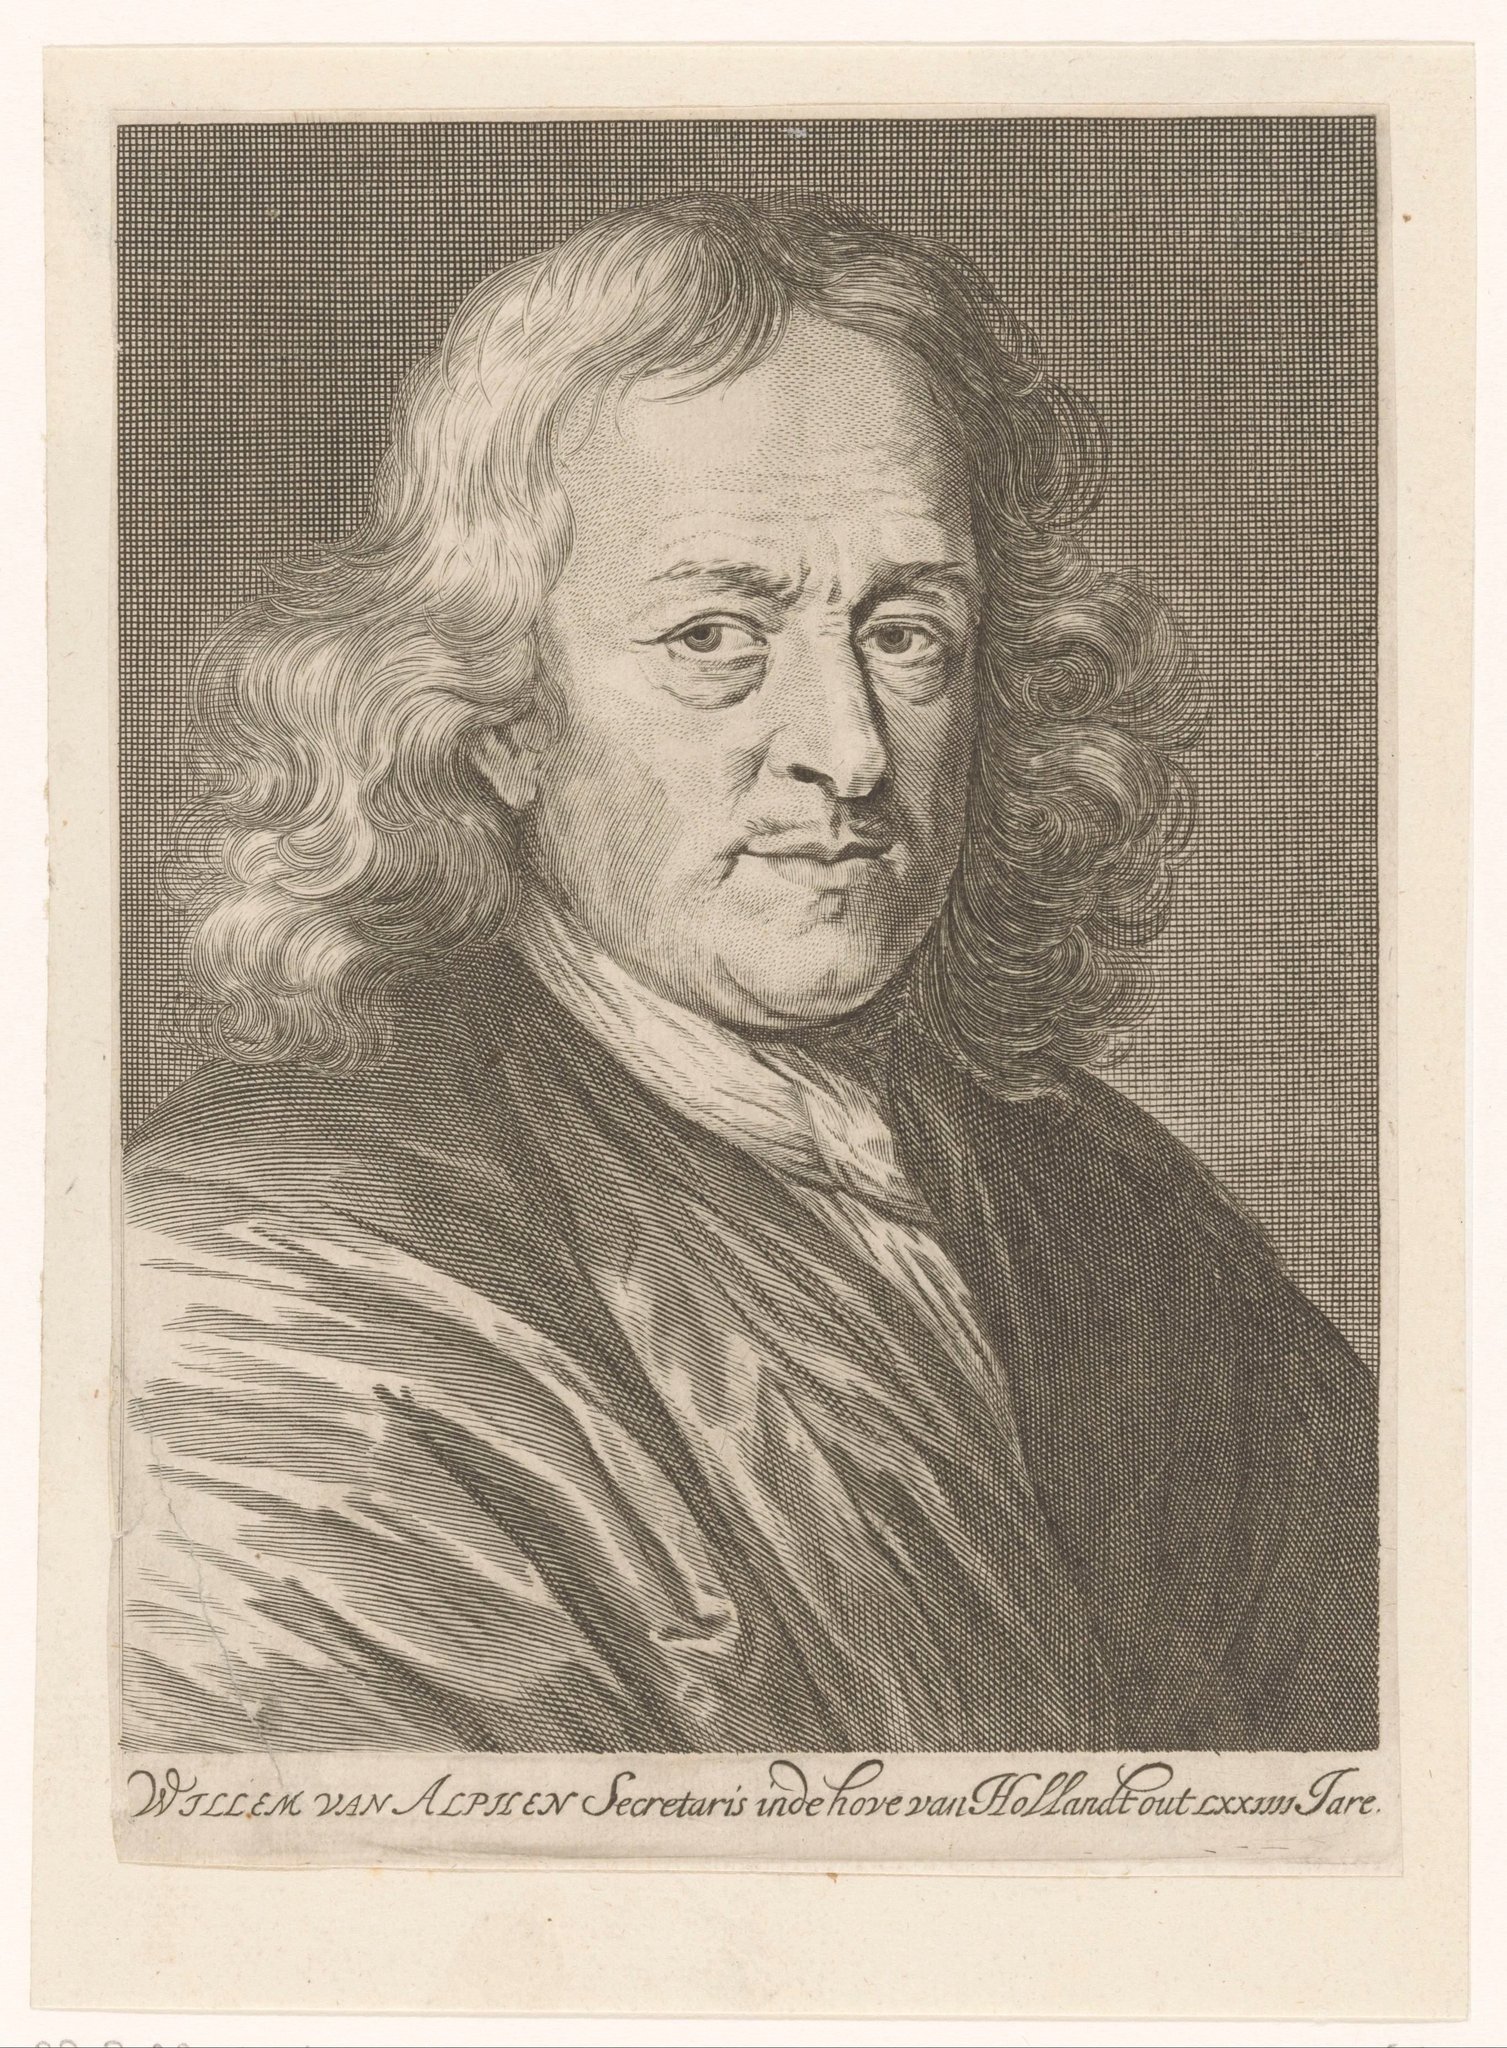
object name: print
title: Portret van Willem van Alphen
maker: Anonymous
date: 1682-1740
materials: paper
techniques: engraving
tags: leiden, the hague, historical persons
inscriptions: collector's mark: Lugt 2228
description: Prent voor het eerst ook gebruikt in: Alphen, Willem van. Papegay, ofte formulier-boek van allerhande requesten, mandamenten, conclusien, schrifturen, als anders (…) Hoven van Justitie in Hollandt. 2 delen. 5e druk. Den Haag: Johannes Steucker, 1682-1683, dl. 1 (1682). De prent komt ook voor in latere drukken van deze publicatie (1712, 1720 en 1740). Uit welke druk het huidige exemplaar komt is niet precies na te gaan.